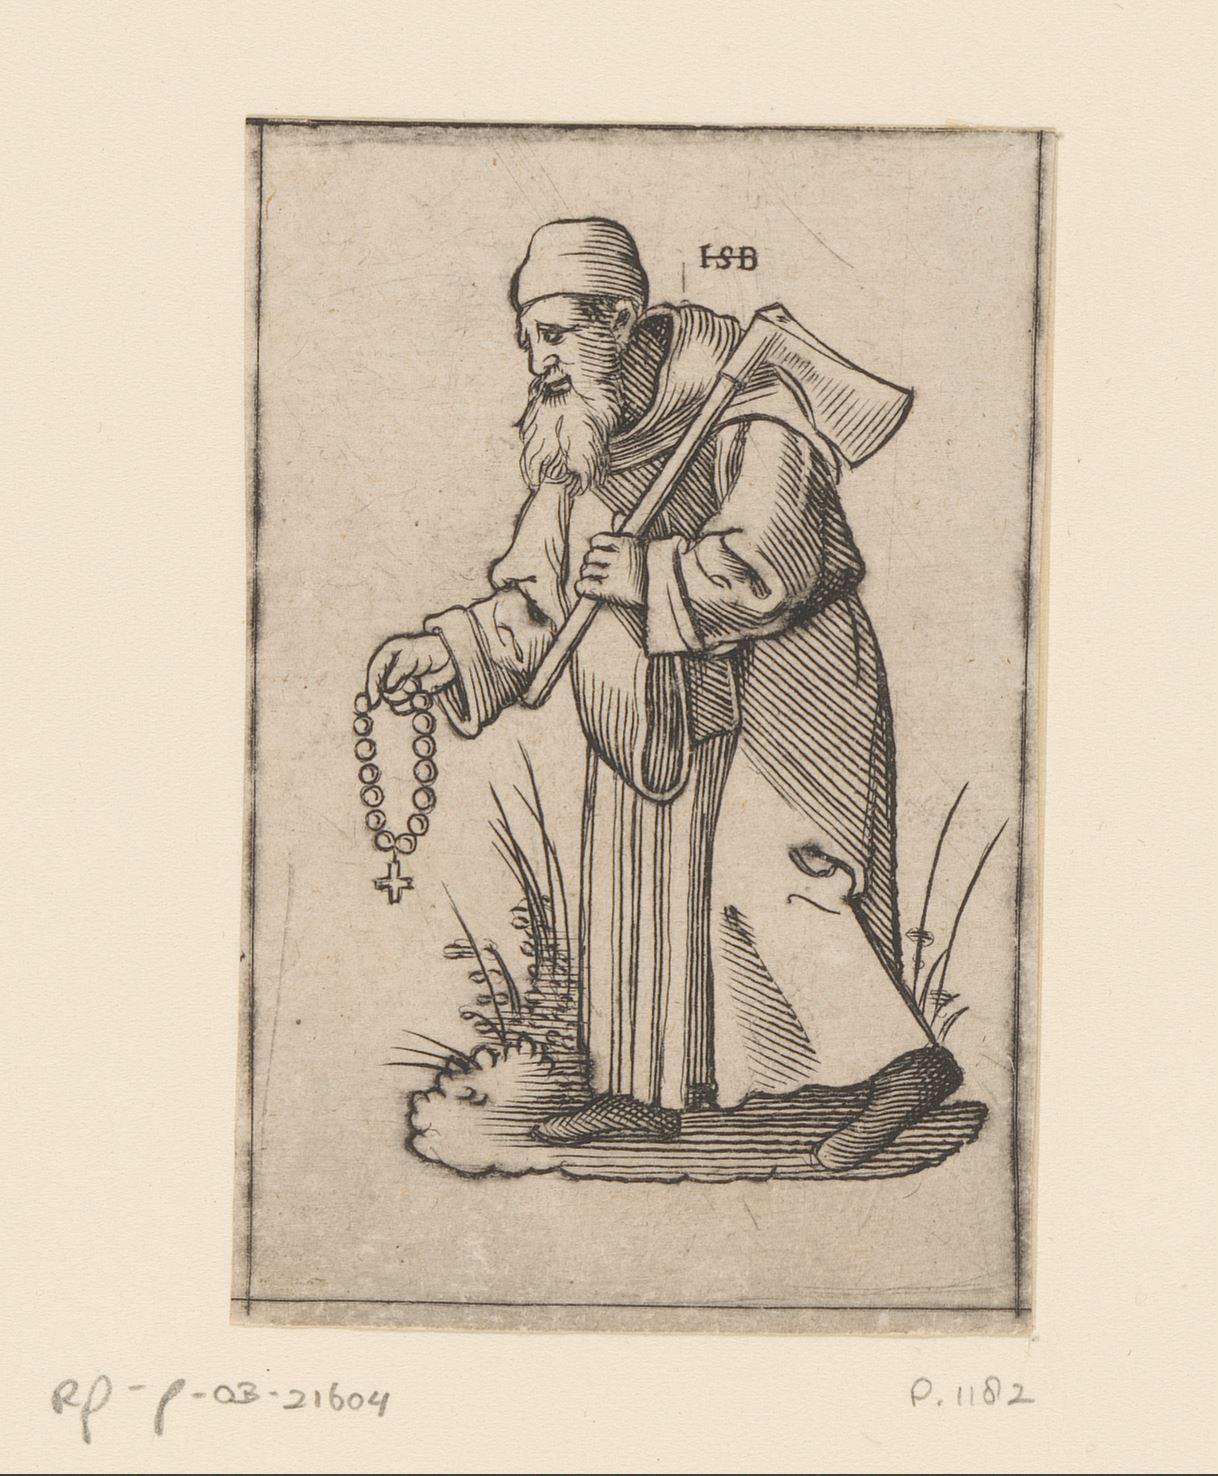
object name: print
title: Kostuums van geestelijken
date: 1526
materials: paper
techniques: engraving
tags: liturgical vestments, canonicals, monastic orders, monastic life ~ roman catholic church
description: Onderdeel van een serie van 28 gegraveerde kopieën in de andere richting naar Hans Sebald Behams "Das Papstthum mit seinen Gliedern", 1526.